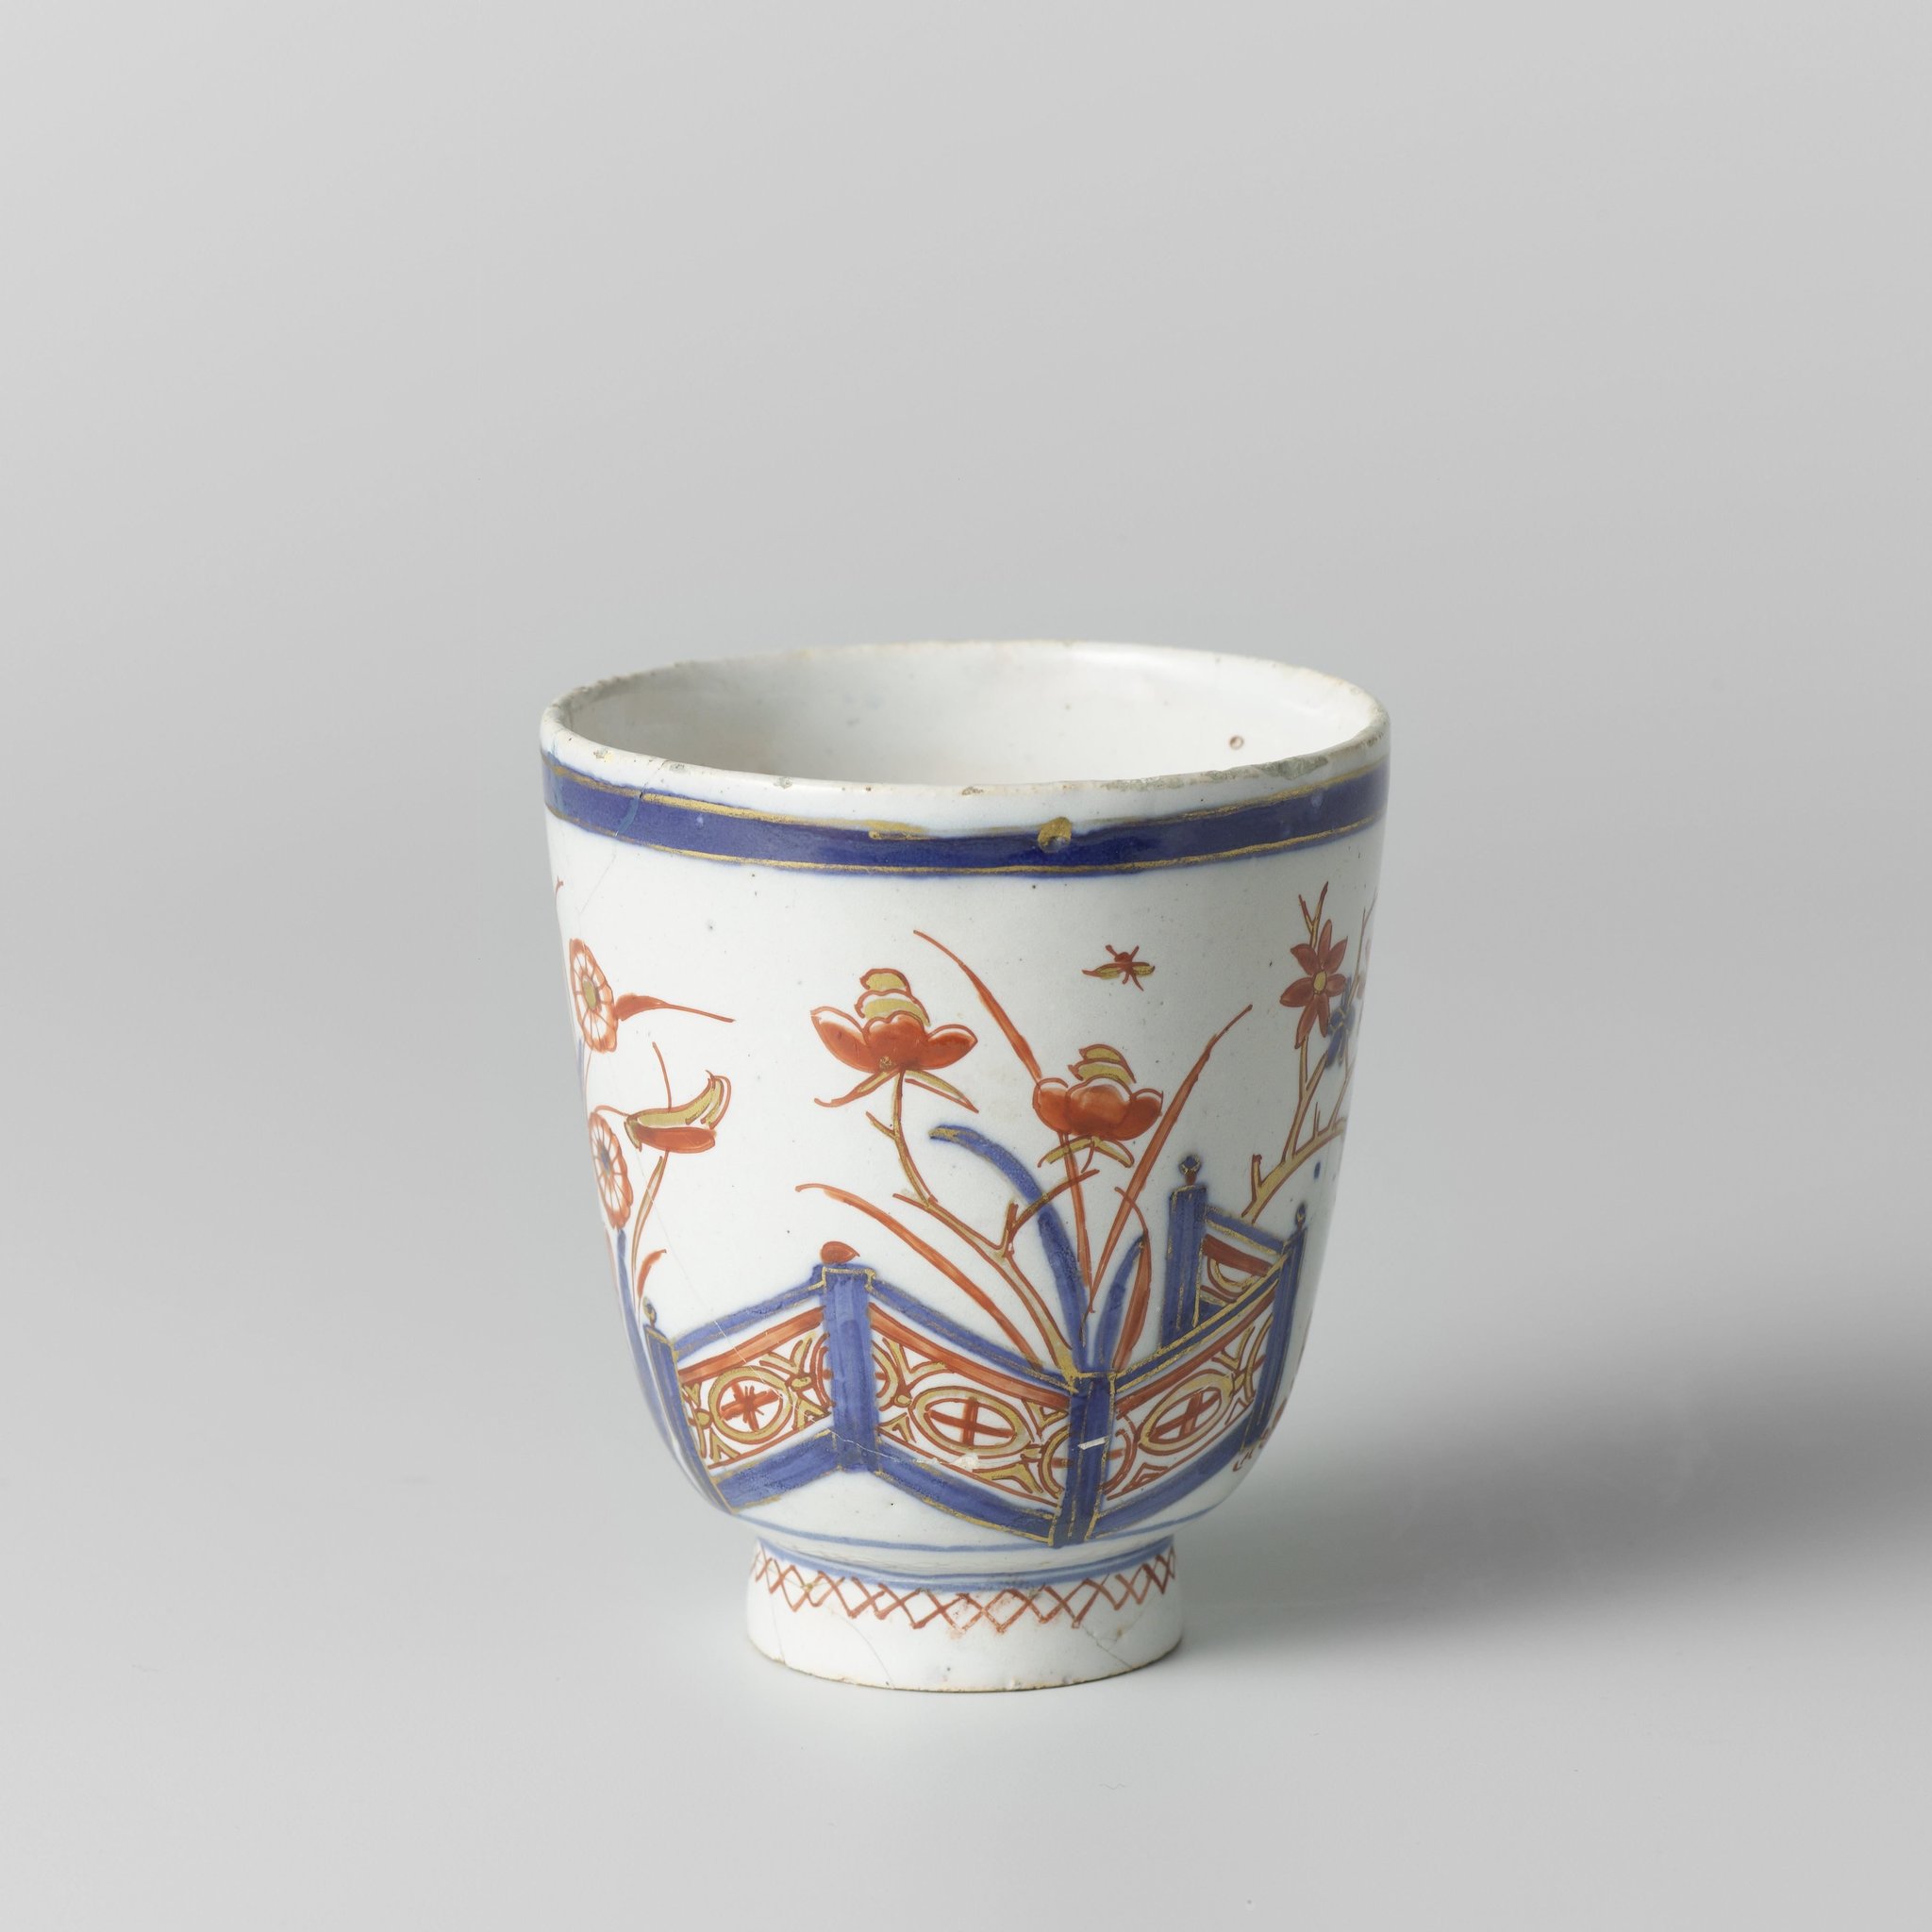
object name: chocolate cup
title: Chocoladekop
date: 1701-1722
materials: faience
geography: delft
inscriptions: mark: ‘APK (ineen)’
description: Kop van faience. Veelkleurig beschilderd met een haan en bloemtakken.